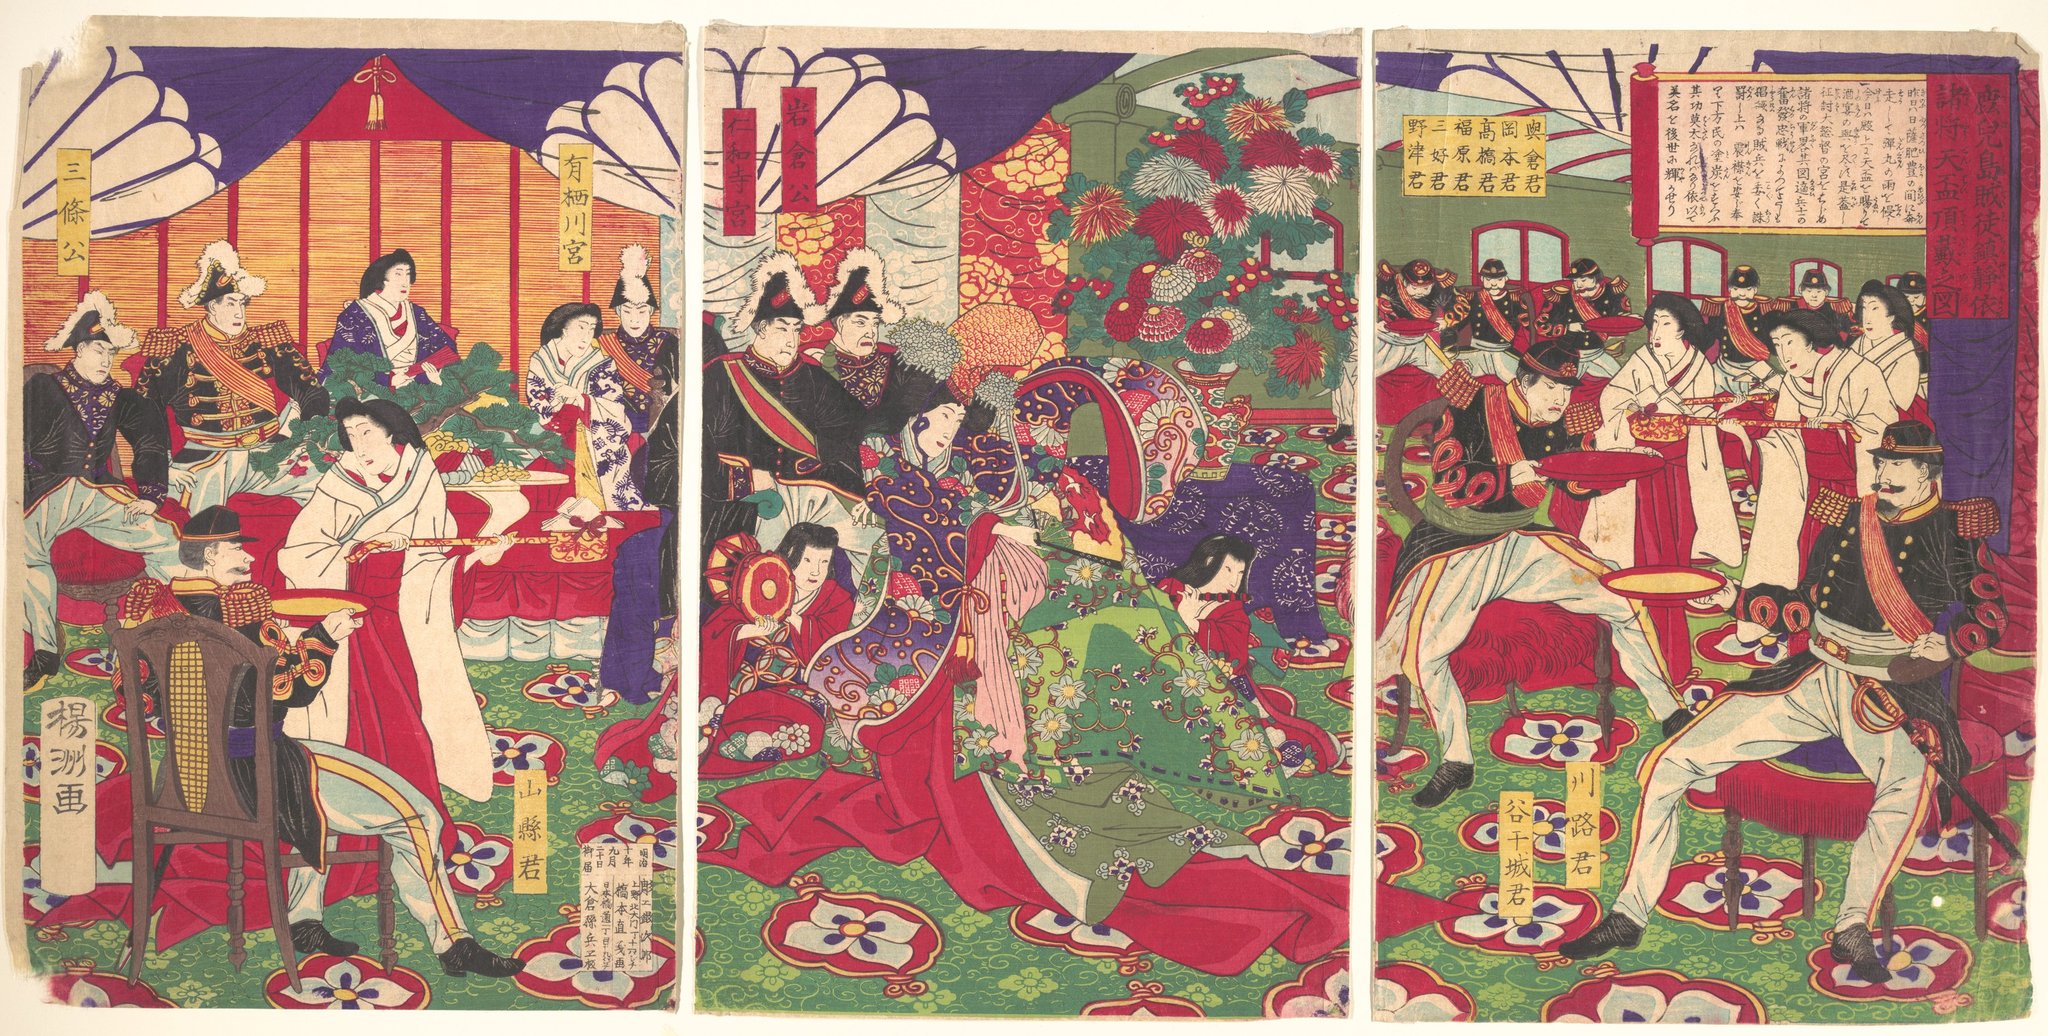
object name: print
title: Leaders of the Pacification of the Kagoshima Rebels Celebrating with Cups of Wine from the Emperor (Kagoshima zokuto chinsei ni yotte shoshō tenhai chōdai no zu)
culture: japanese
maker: yōshū (hashimoto) chikanobu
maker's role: artist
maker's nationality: japanese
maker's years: 1838-1912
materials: ink, paper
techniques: woodblock print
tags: military,emperors,men,women